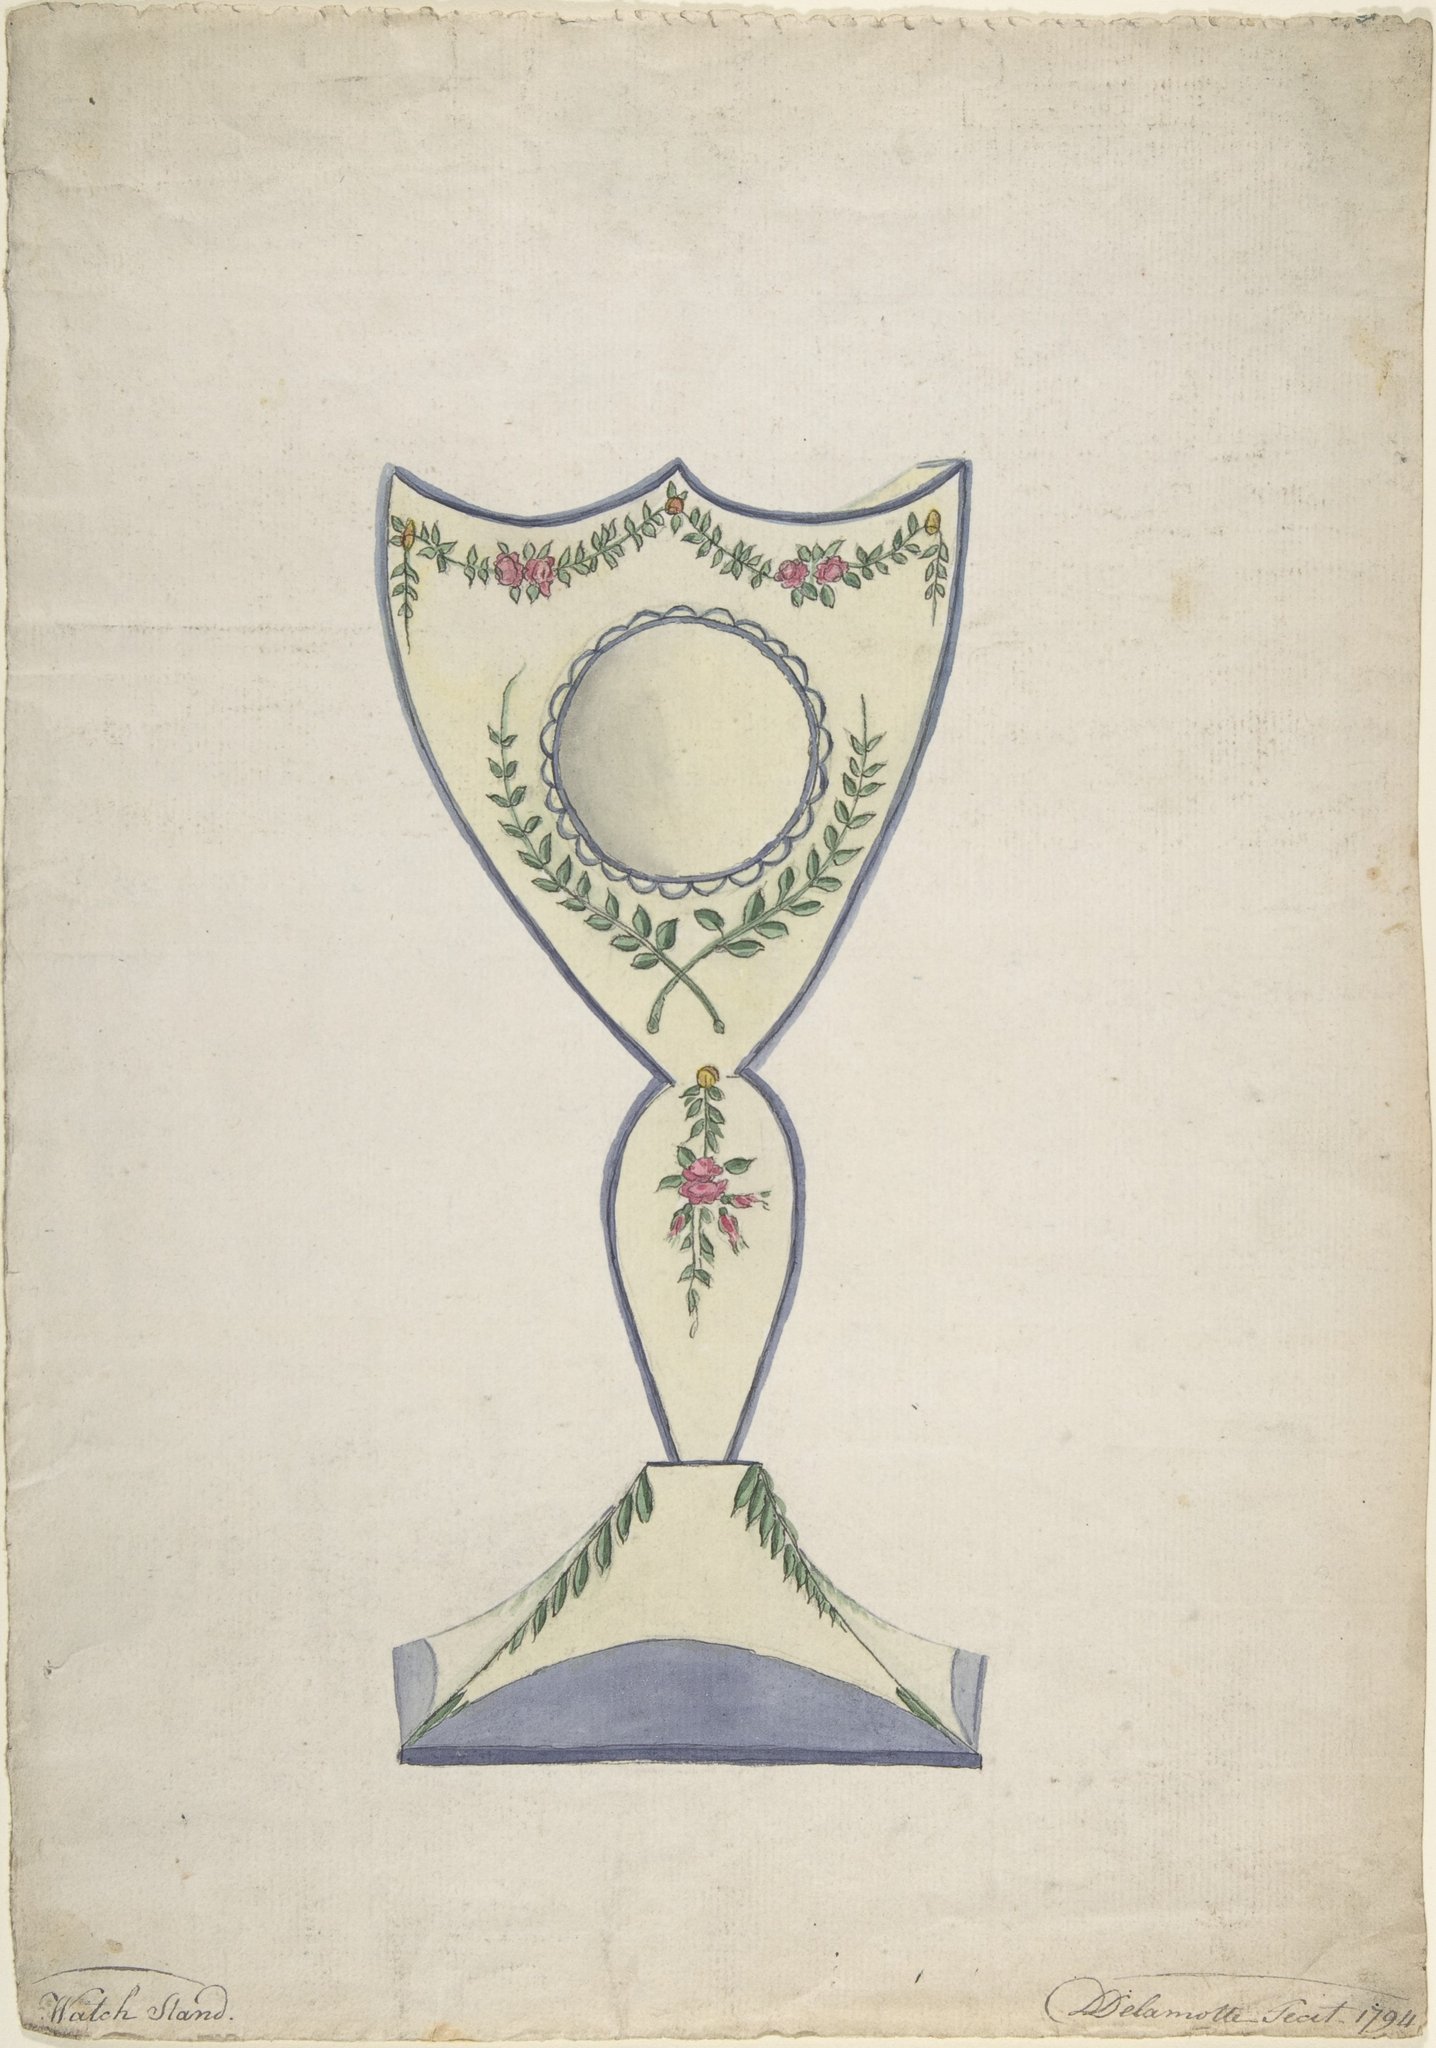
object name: drawing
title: Watch Design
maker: delamotte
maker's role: artist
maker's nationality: french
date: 1794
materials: ink, paper, watercolor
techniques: pen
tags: flowers,leaves